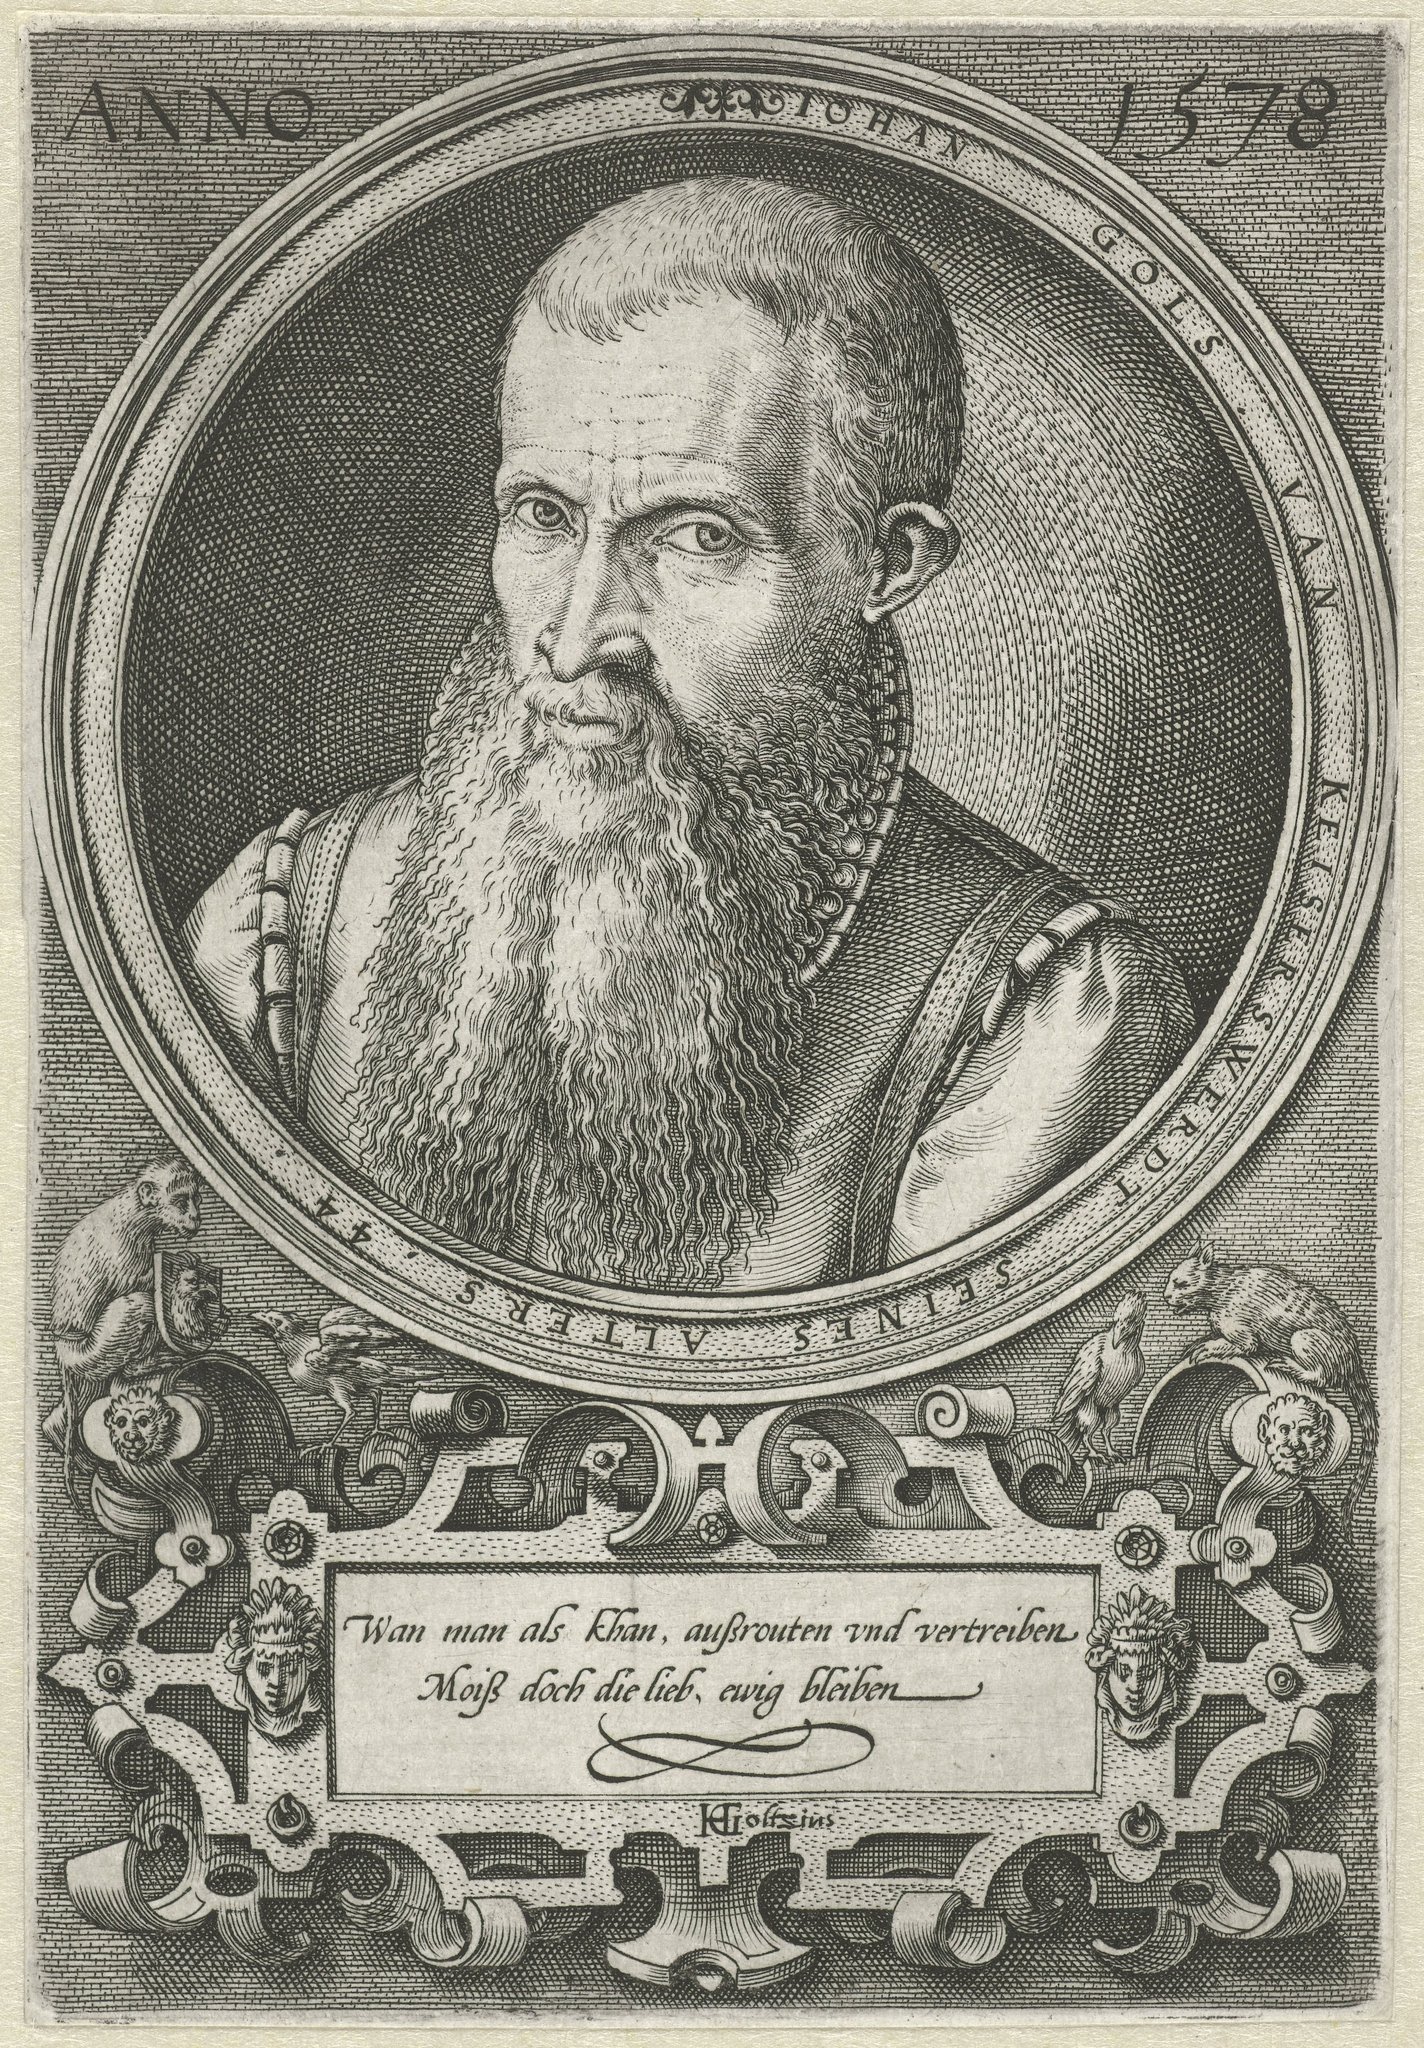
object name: print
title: Portret van Johann Goltz van Keiserswerdt op 44-jarige leeftijd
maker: hendrick goltzius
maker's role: draughtsman, painter, print maker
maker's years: 1558-1617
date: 1578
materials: paper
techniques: engraving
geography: haarlem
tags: johann goltz, portrait, self-portrait of artist, beard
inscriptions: collector's mark: Lugt 240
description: Portret van Johann Goltz van Keiserswerdt, glasschilder en de vader van de kunstenaar, in medaillon met randschrift. Onder de voorstelling twee regels Duitse tekst in een cartouche die versiert is met een aap, vogels en een katachtige.